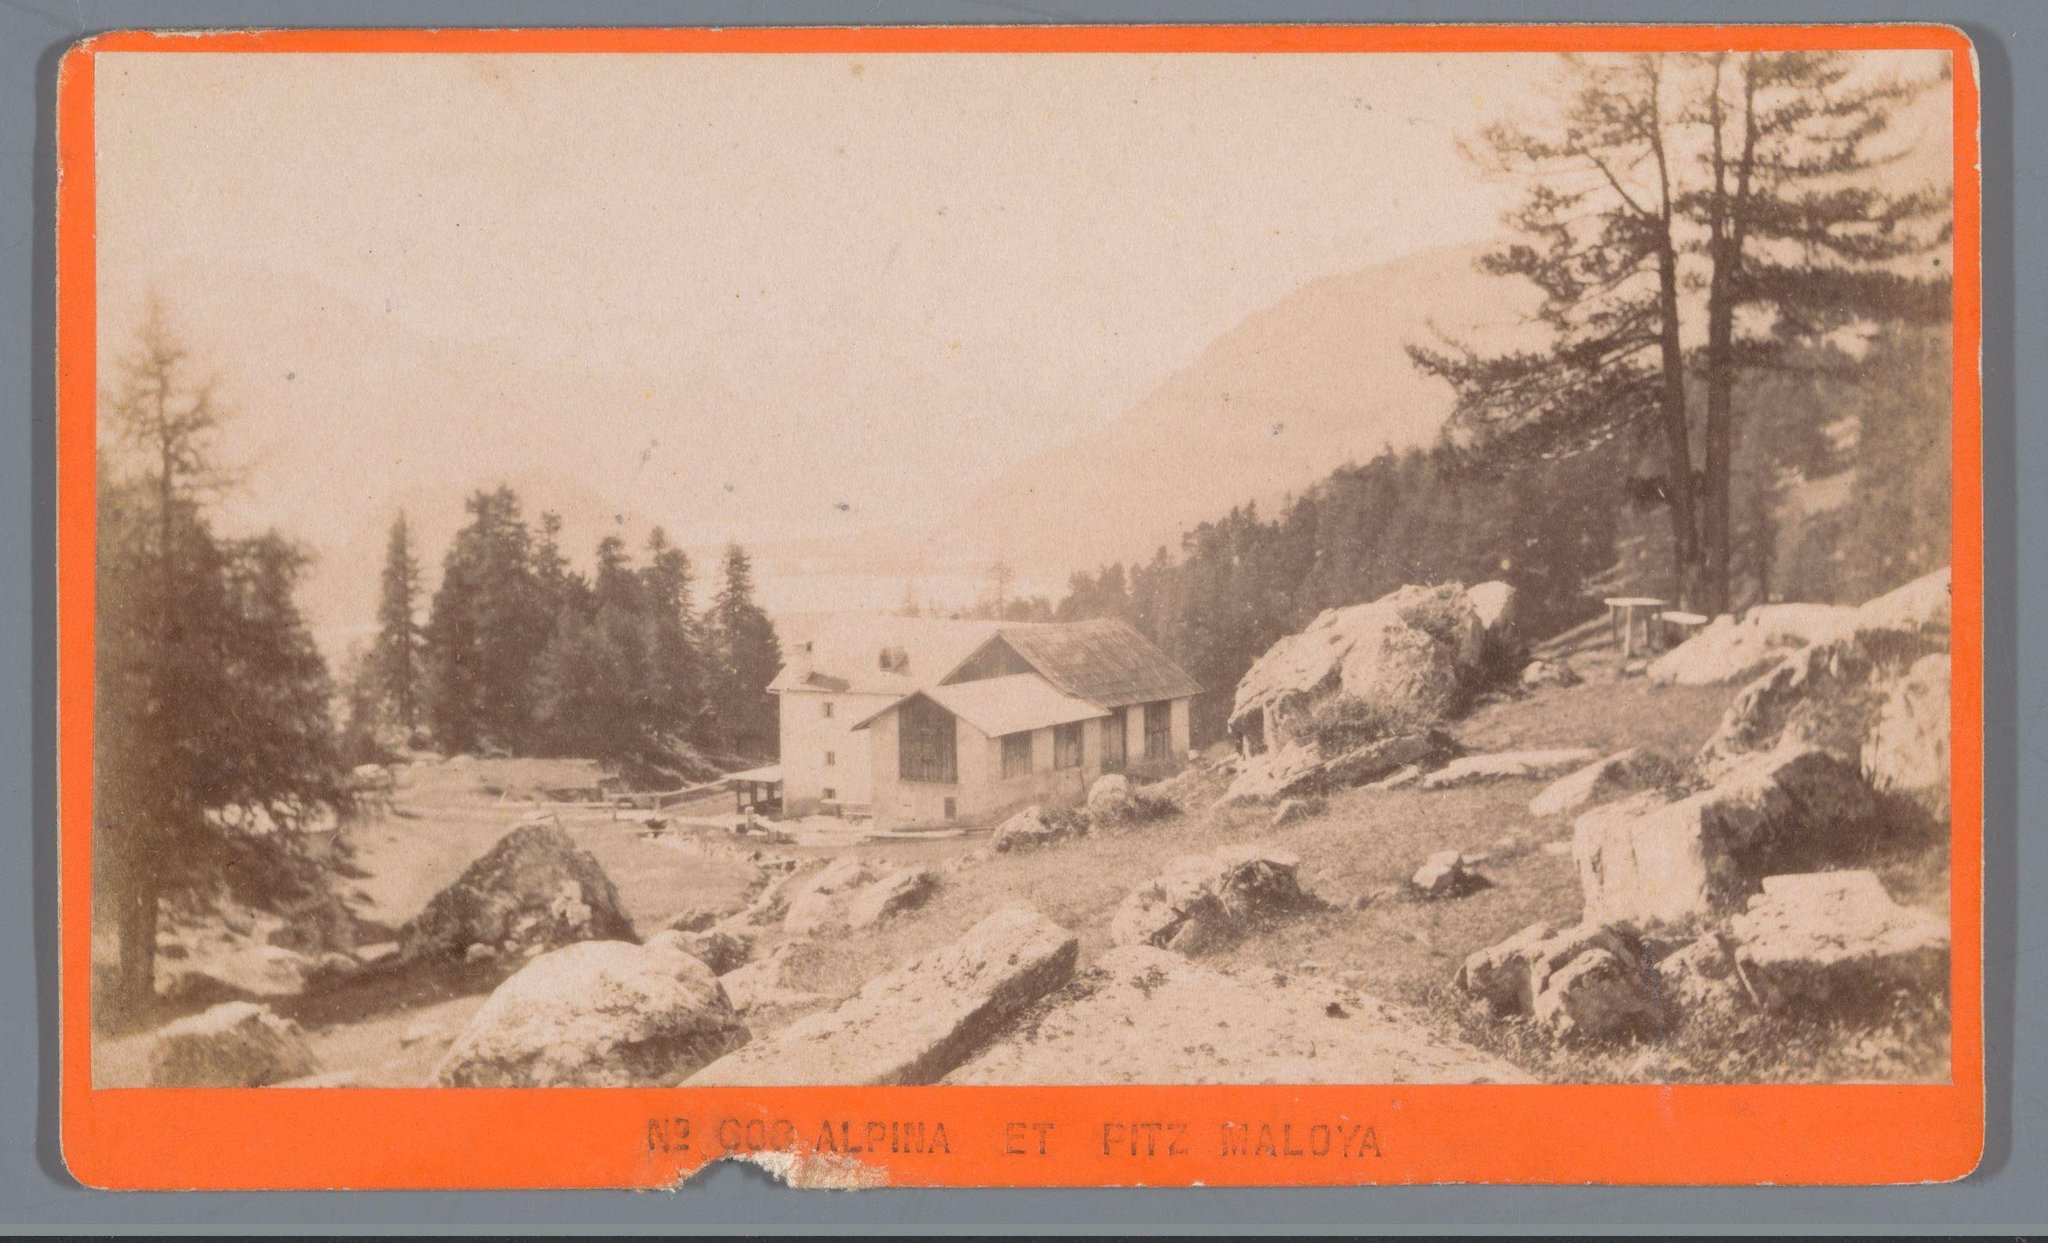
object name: carte de visite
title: Alpina et Pitz Maloya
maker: florentin charnaux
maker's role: publisher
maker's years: 1819-1883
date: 1873-1883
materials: cardboard, paper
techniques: albumen print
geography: malojapas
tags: mountains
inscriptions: inscription: ‘PARIS 1870/ LYON 1872/ VIENNE 1873/ MAISON DES TROIS ROIS’, number: ‘No 608’